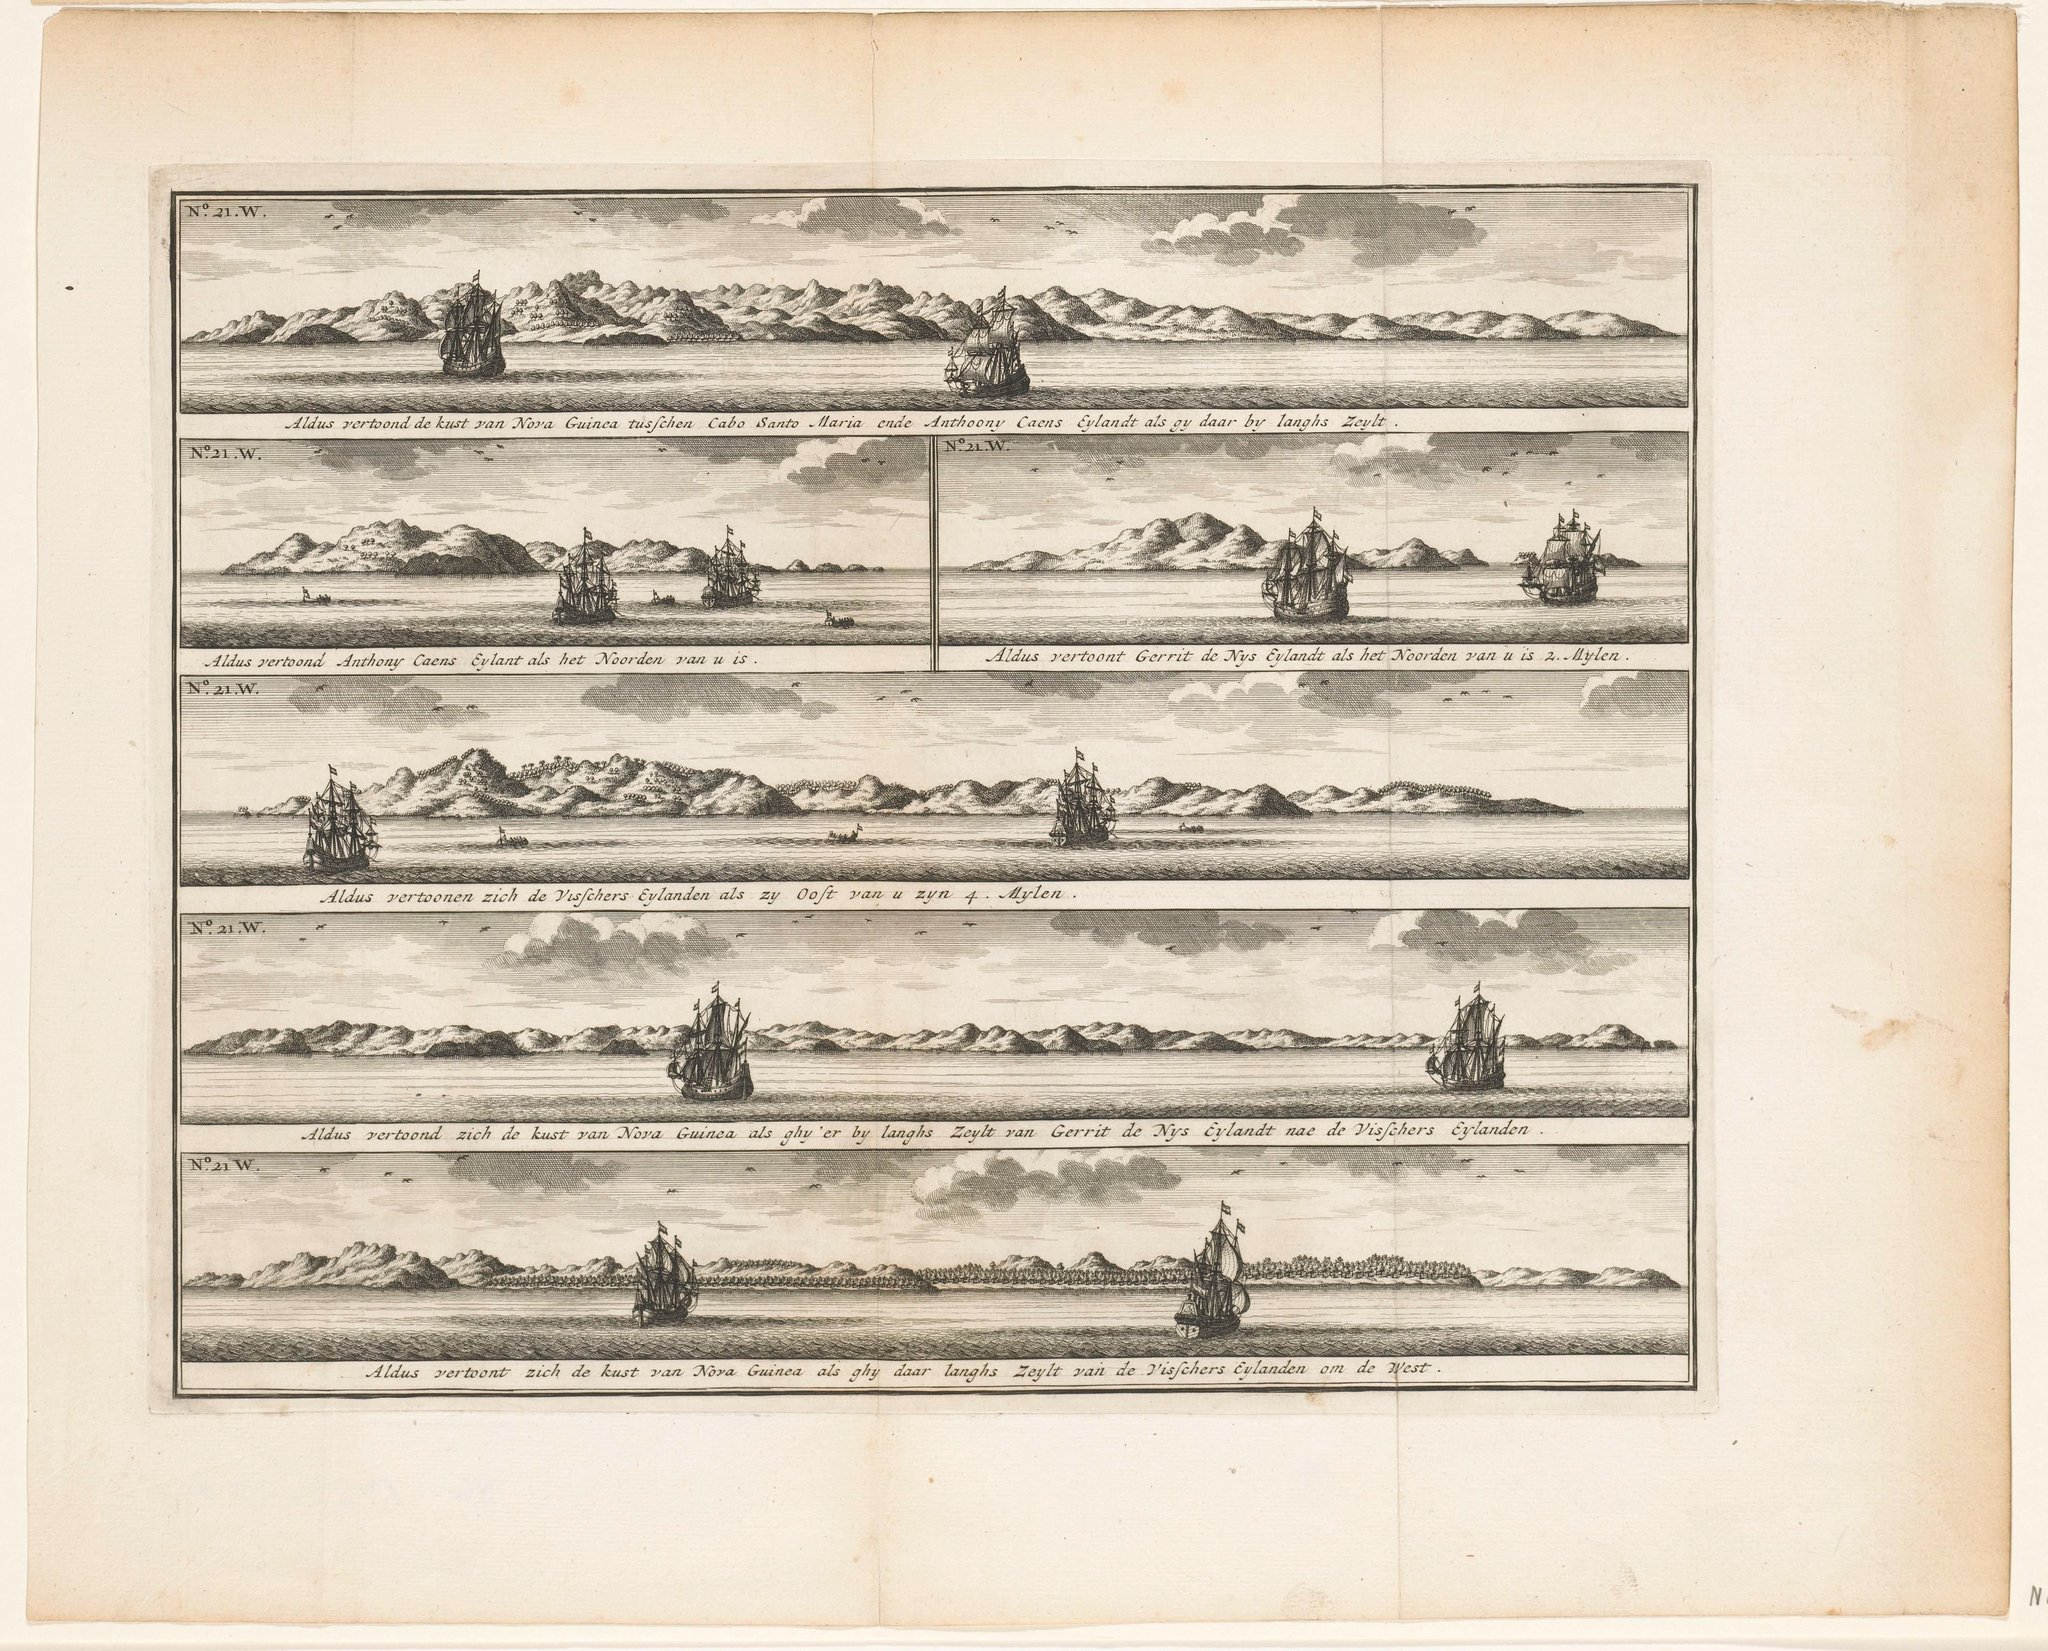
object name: print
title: Aldus vertoond de kust van Nova Guinea tuschen Cabo Santo Maria ende Anthony Caens Eylandt als gy daar langhs Zeylt / Aldus vertoond Anthony Caens Eylant als het Noorden van u is / Aldus vertoont Gerrit de Nys Eylandt als het Noorden van u is 2. Mylen / Aldus vertoonen zich de Visschers Eylanden als zij Oost van u zijn 4. Mylen / Aldus vertoond zich de kust van Nova Guinea als ghy 'er by langhs Zeylt van Gerrit de Nys Eylandt nae de Visschers Eylanden / Aldus vertoont zich de kust van Nova Guinea als ghy daar langhs Zeylt van de Visschers Eylanden om de West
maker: Anonymous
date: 1722-1724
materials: paper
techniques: etching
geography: netherlands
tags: island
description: Blad met zes kustgezichten van verschillende eilanden en eilandgroepen, naast en onder elkaar; voor elke kust twee zeilschepen. Het betreft Nieuw-Guinea, Nieuw-Ierland en andere eilanden genaamd Anthony Caens Eiland, Gerrit de Nys Eiland en de Visschers Eilanden, waarschijnlijk onderdeel van het huidige Bismarck-archipel. De afbeeldingen zijn alle vier genummerd 21 W. Illustratie uit: Beschryving van Amboina (1724).